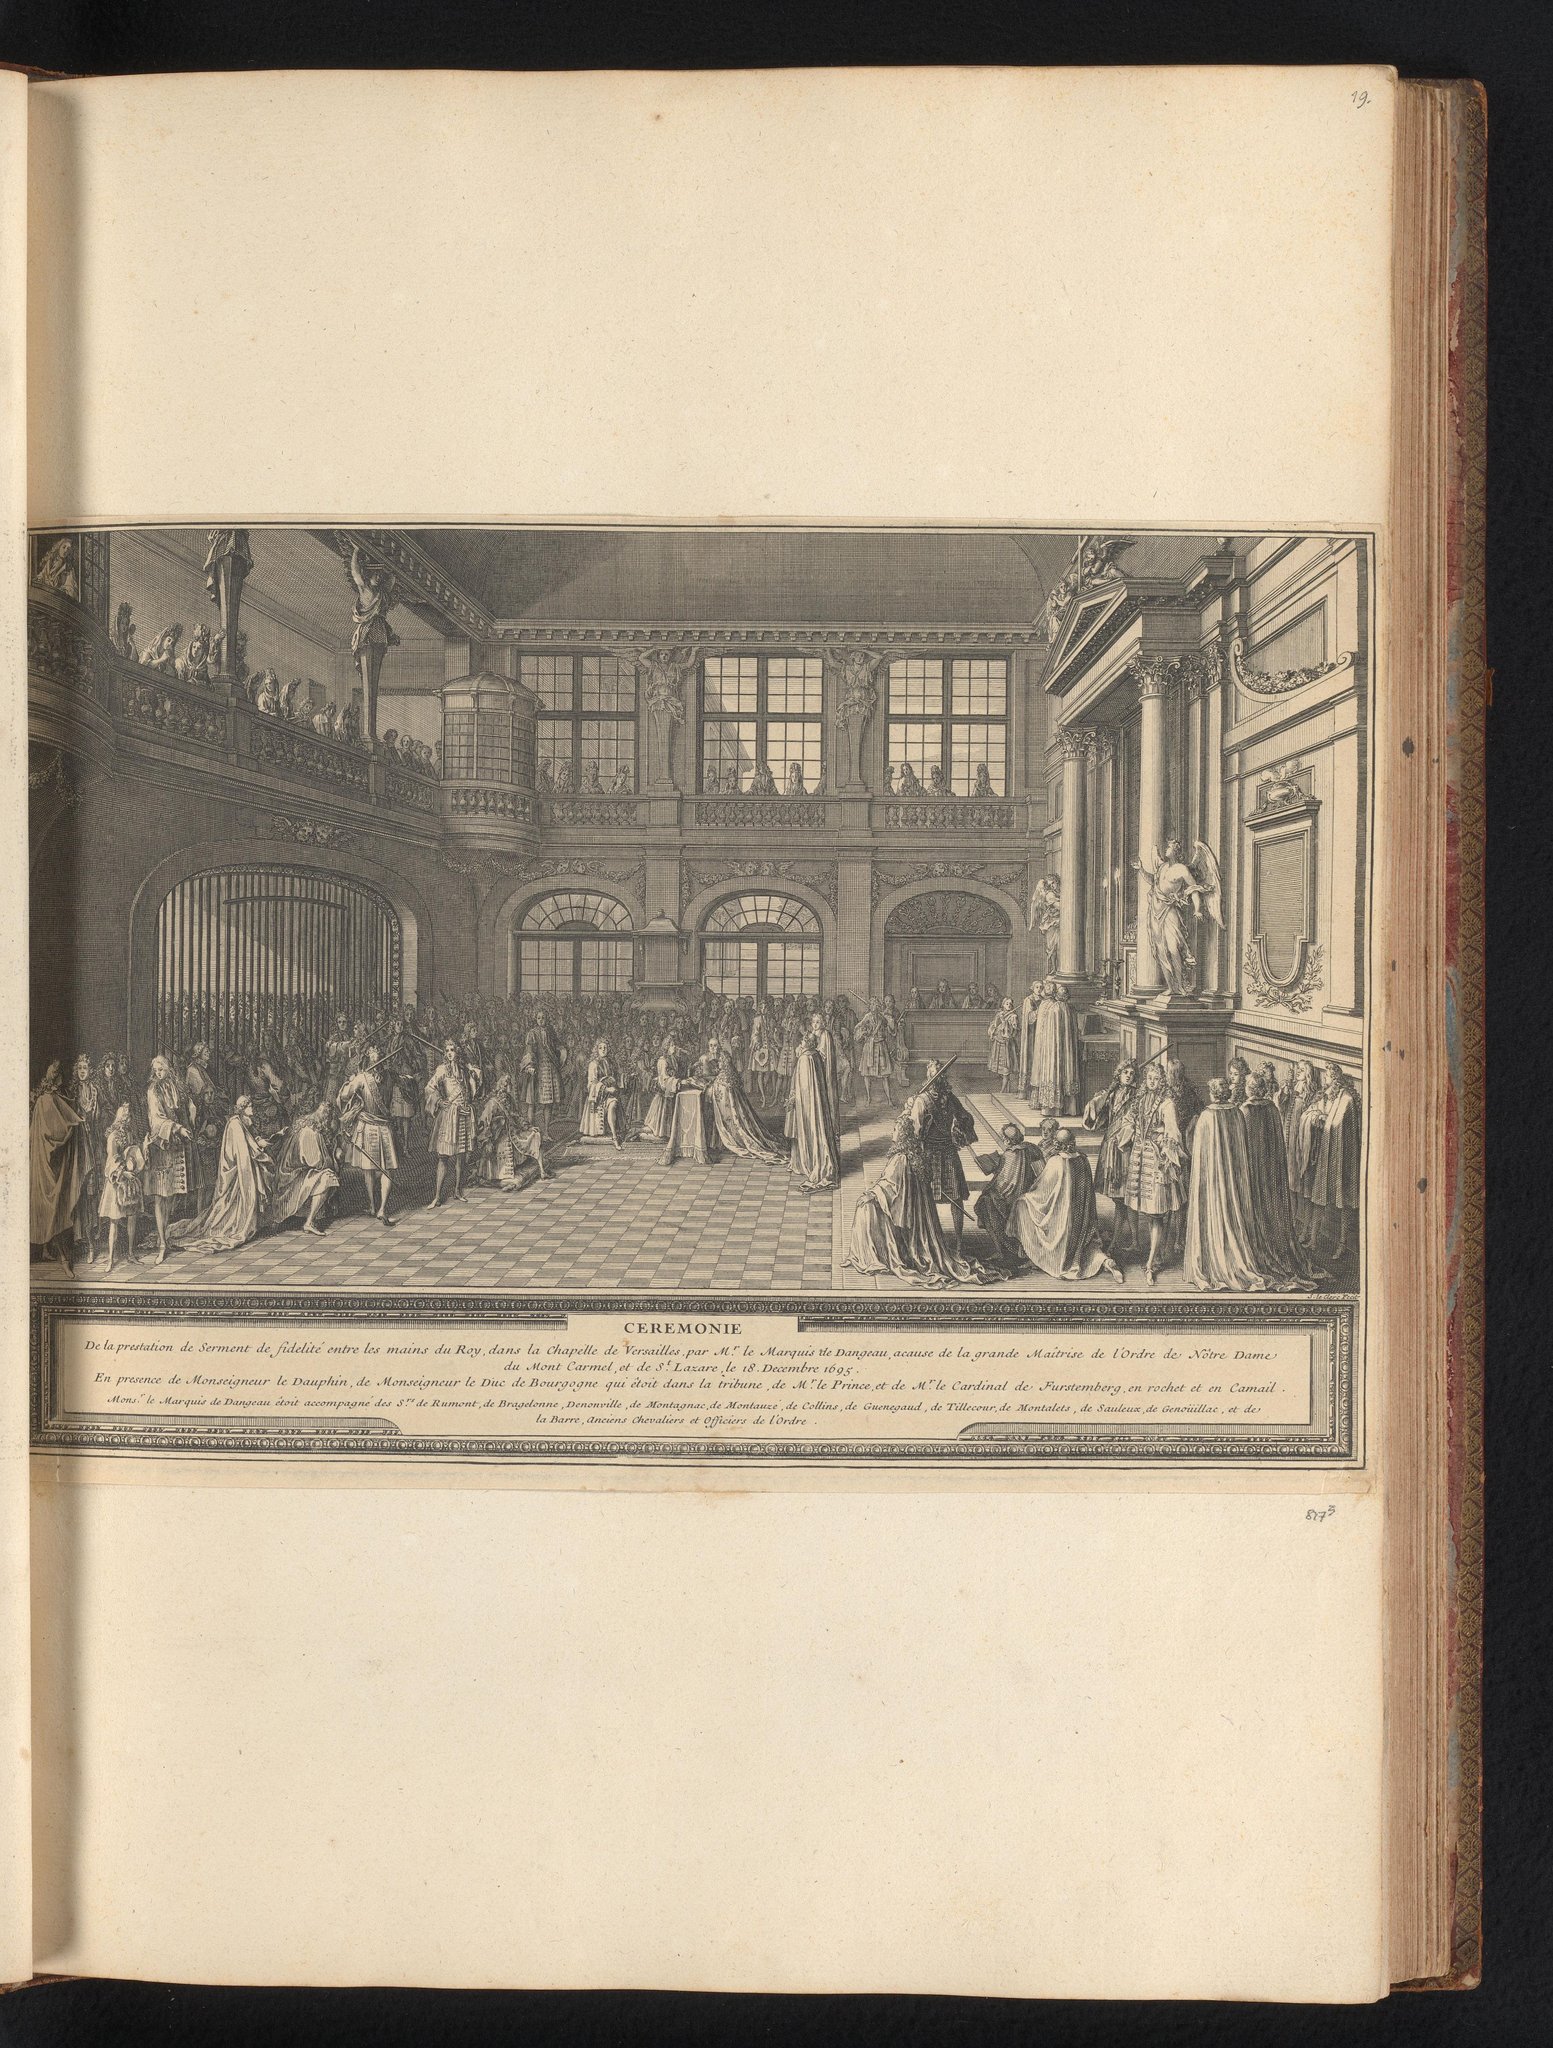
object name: print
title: Philippe de Courcillon zweert trouw aan koning Lodewijk XIV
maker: sébastien leclerc (i)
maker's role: print maker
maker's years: 1637-1714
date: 1700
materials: paper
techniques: etching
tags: lodewijk xiv (koning van frankrijk), historical persons, swearing allegiance to a ruler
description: Ceremonie op 18 december 1695. Prent maakt deel uit van een album.